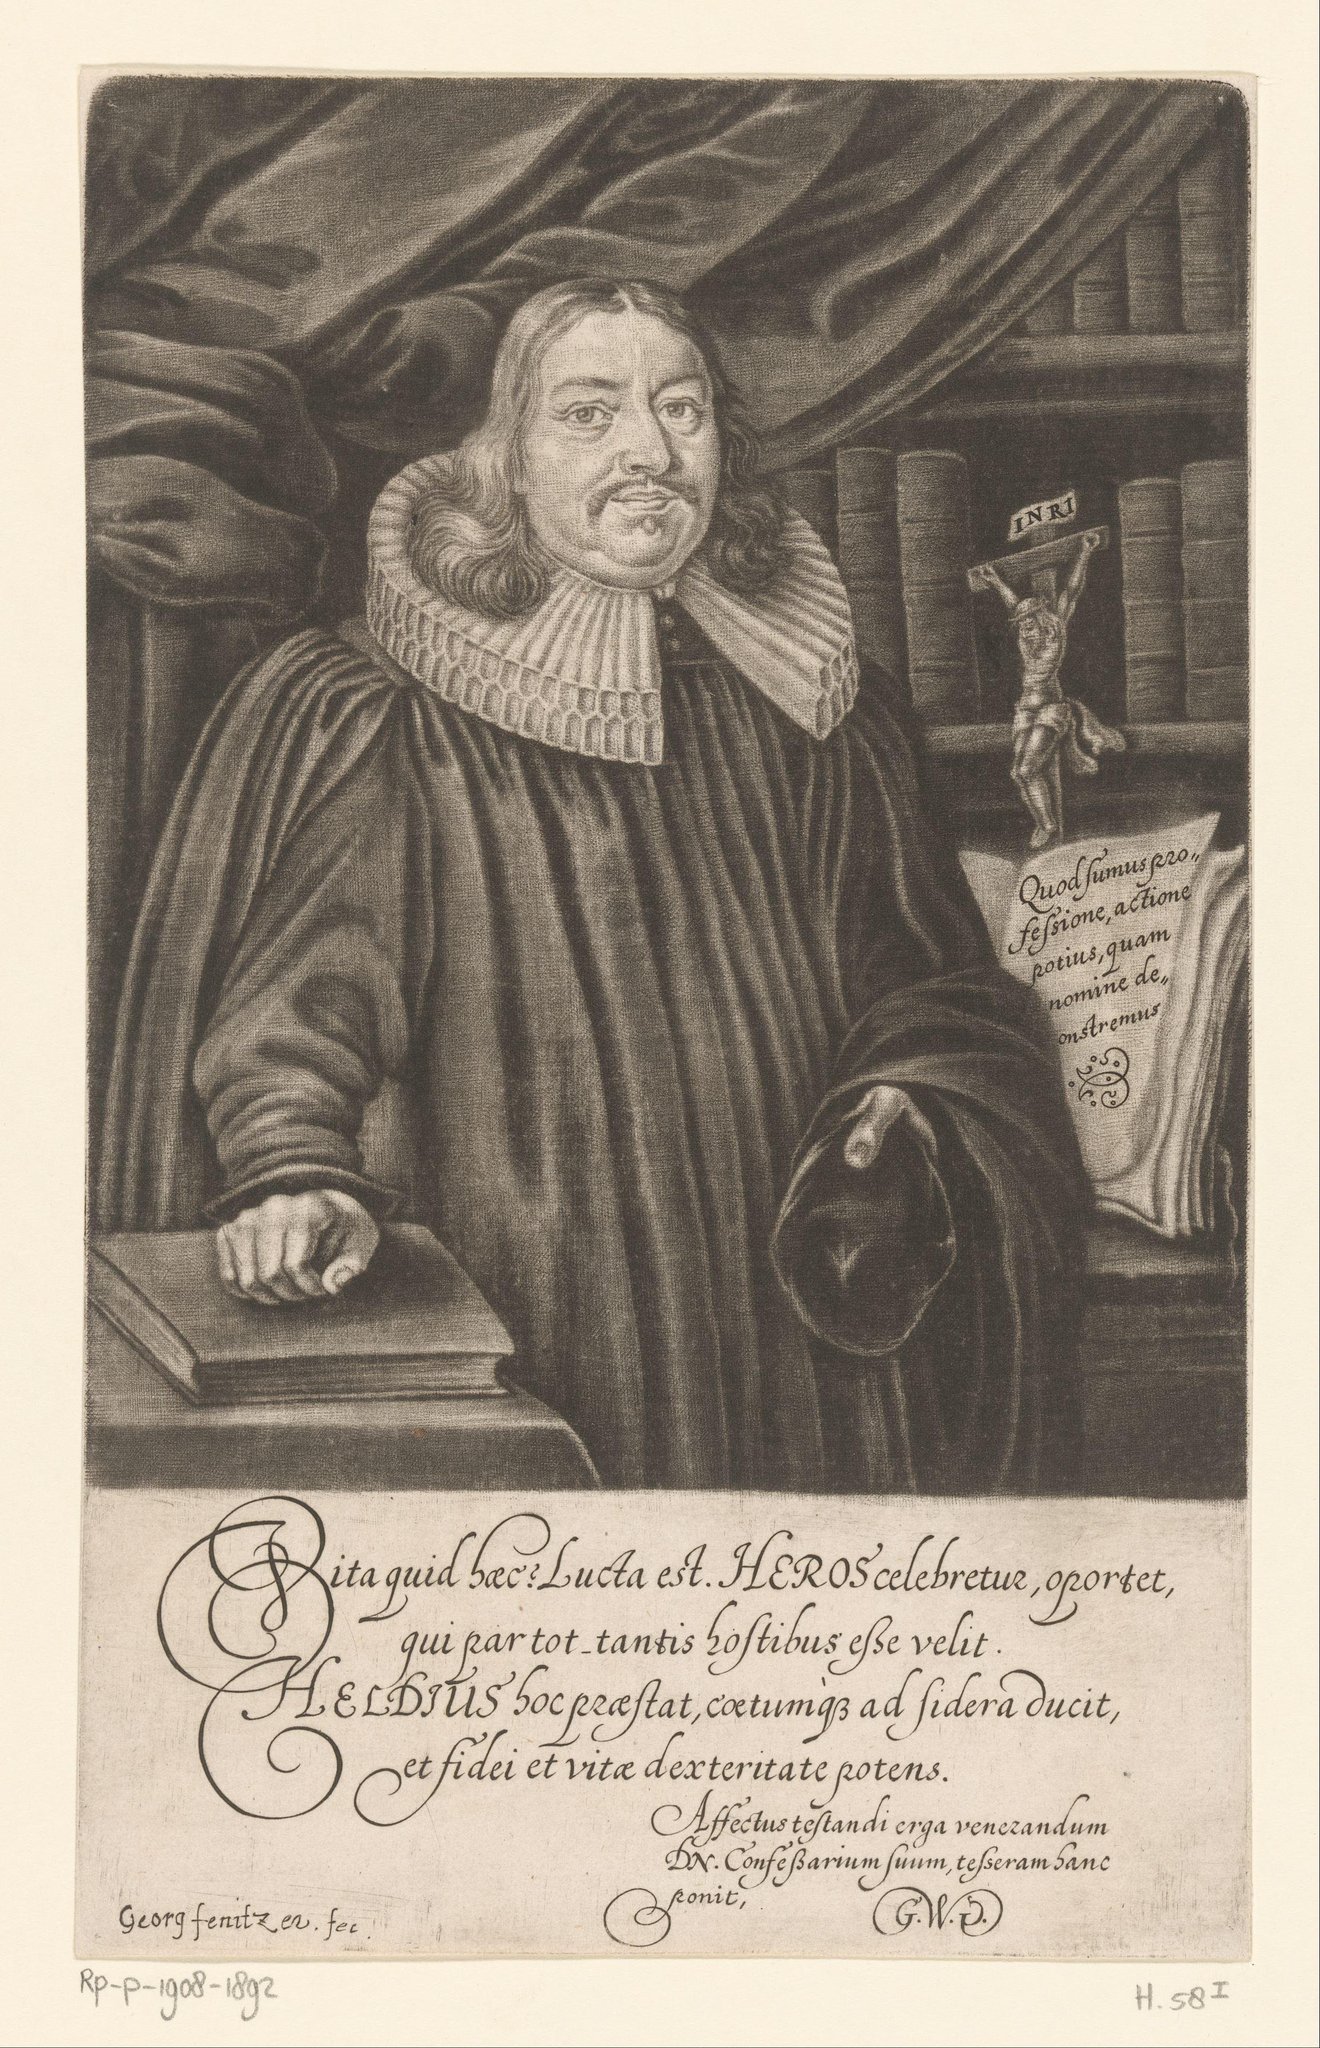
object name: print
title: Portret van Johann Held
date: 1656-1722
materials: paper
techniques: etching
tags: bookshelves, historical persons, deacon (roman catholic), book, crucifix ~ personal devotion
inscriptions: collector's mark: Lugt 2228